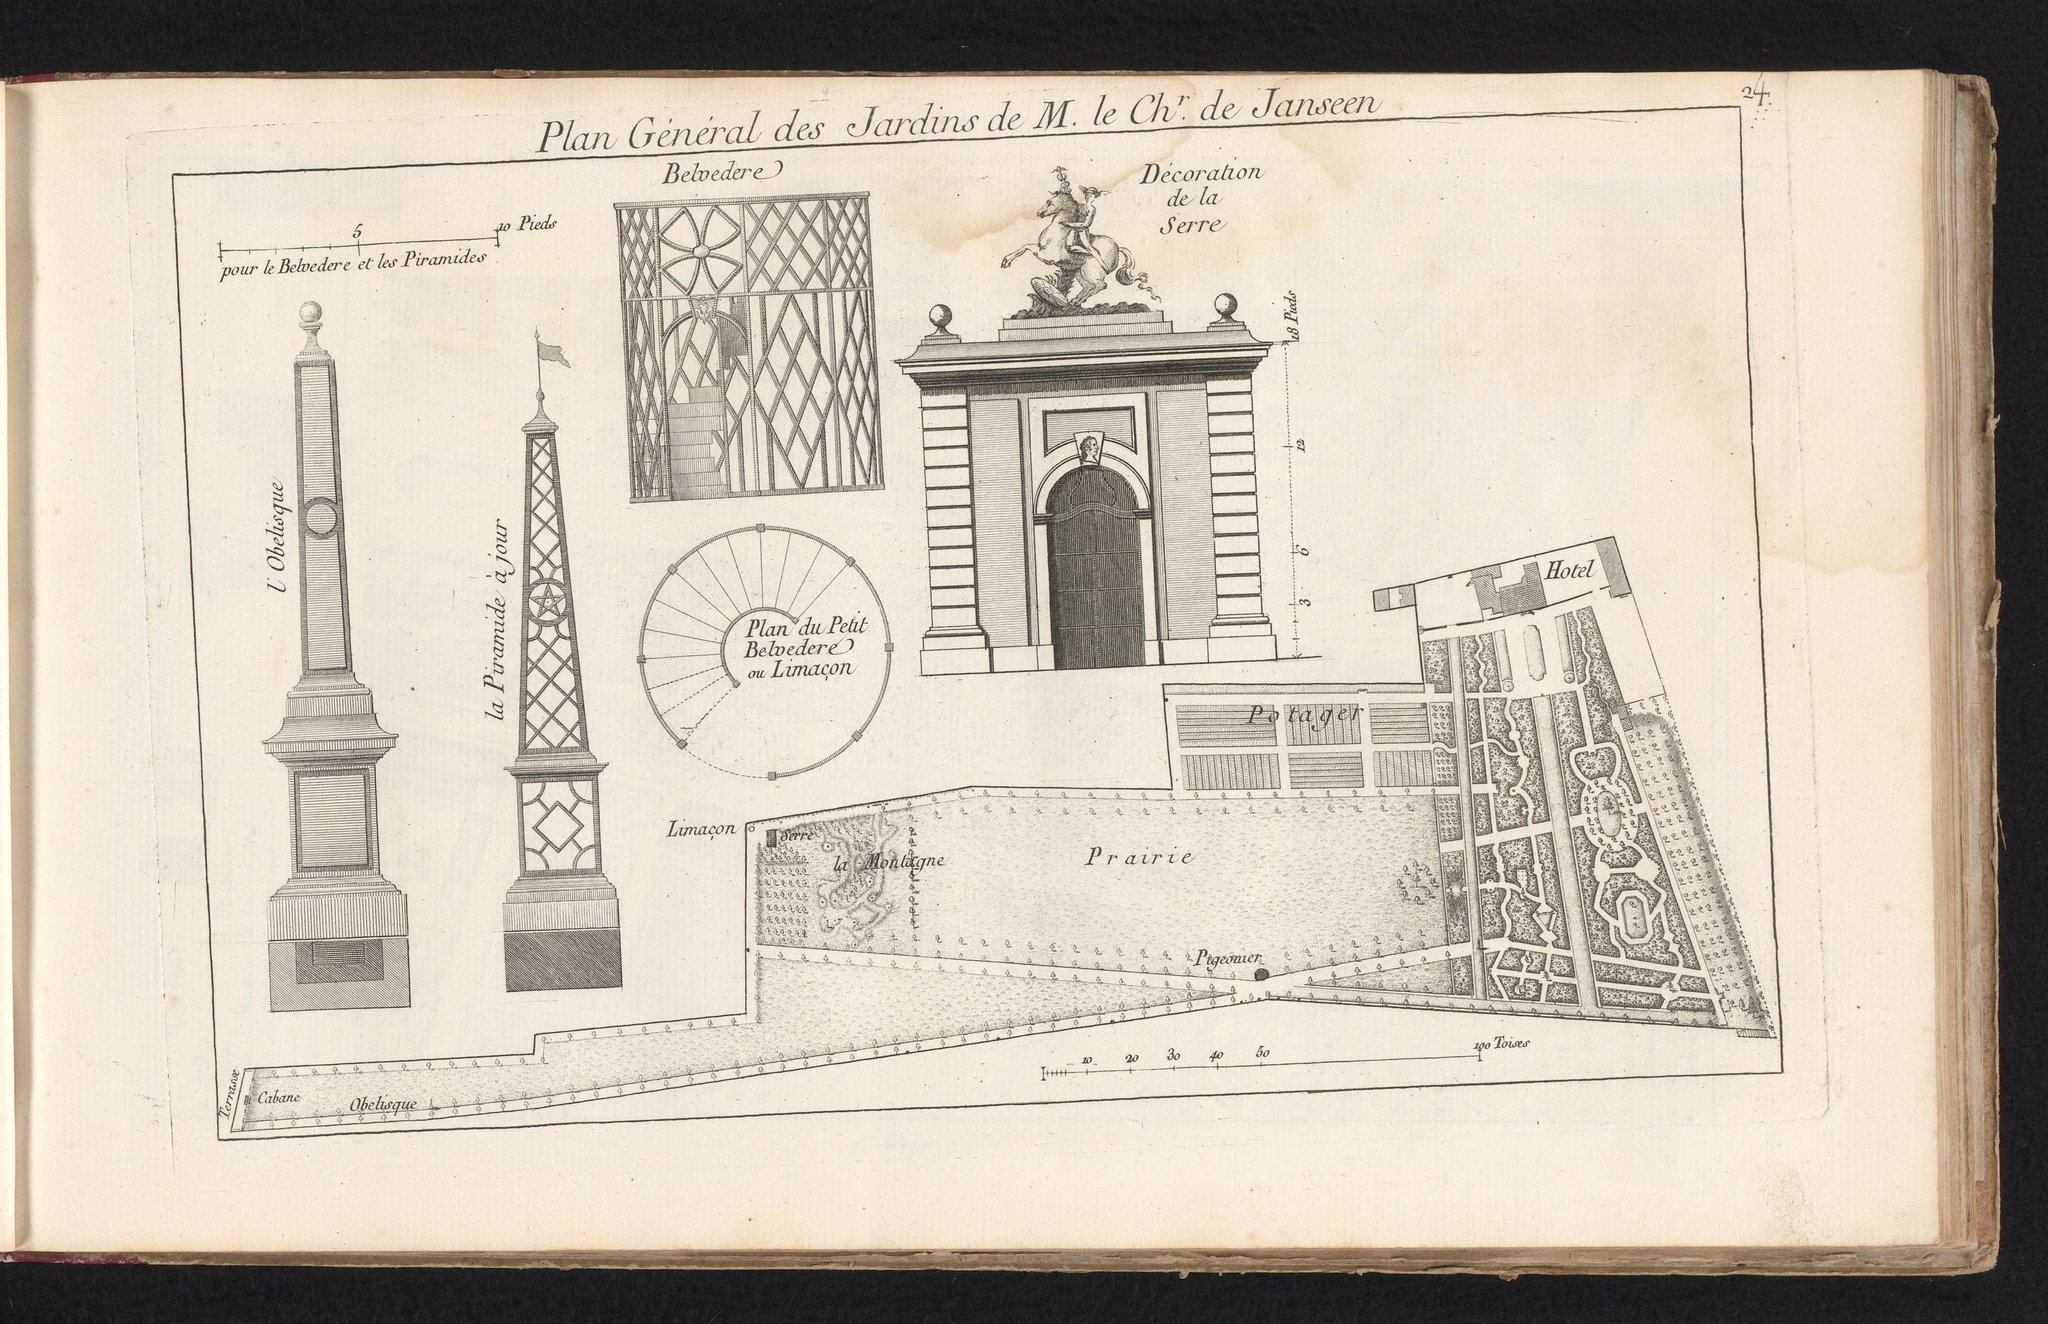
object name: album leaf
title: Plattegrond van en bouwwerken in de tuin van het Hôtel de Jansen in Parijs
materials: paper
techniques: engraving, etching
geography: paris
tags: plan, map of garden, garden buildings, paris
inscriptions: collector's mark: Lugt 2228, collector's mark: Lugt 2760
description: De serie 'Jardins anglo-chinois à la mode' verscheen in totaal in 21 zogeheten 'cahiers' (afleveringen). De huidige prent komt uit het zesde 'cahier'. Het Rijksmuseum Amsterdam bezit drie banden met daarin in totaal zes 'cahiers' van deze reeks. In de documentatie wordt verwezen naar een in de bibliotheek van het Rijksmuseum Amsterdam aanwezige facsimile van het complete werk.